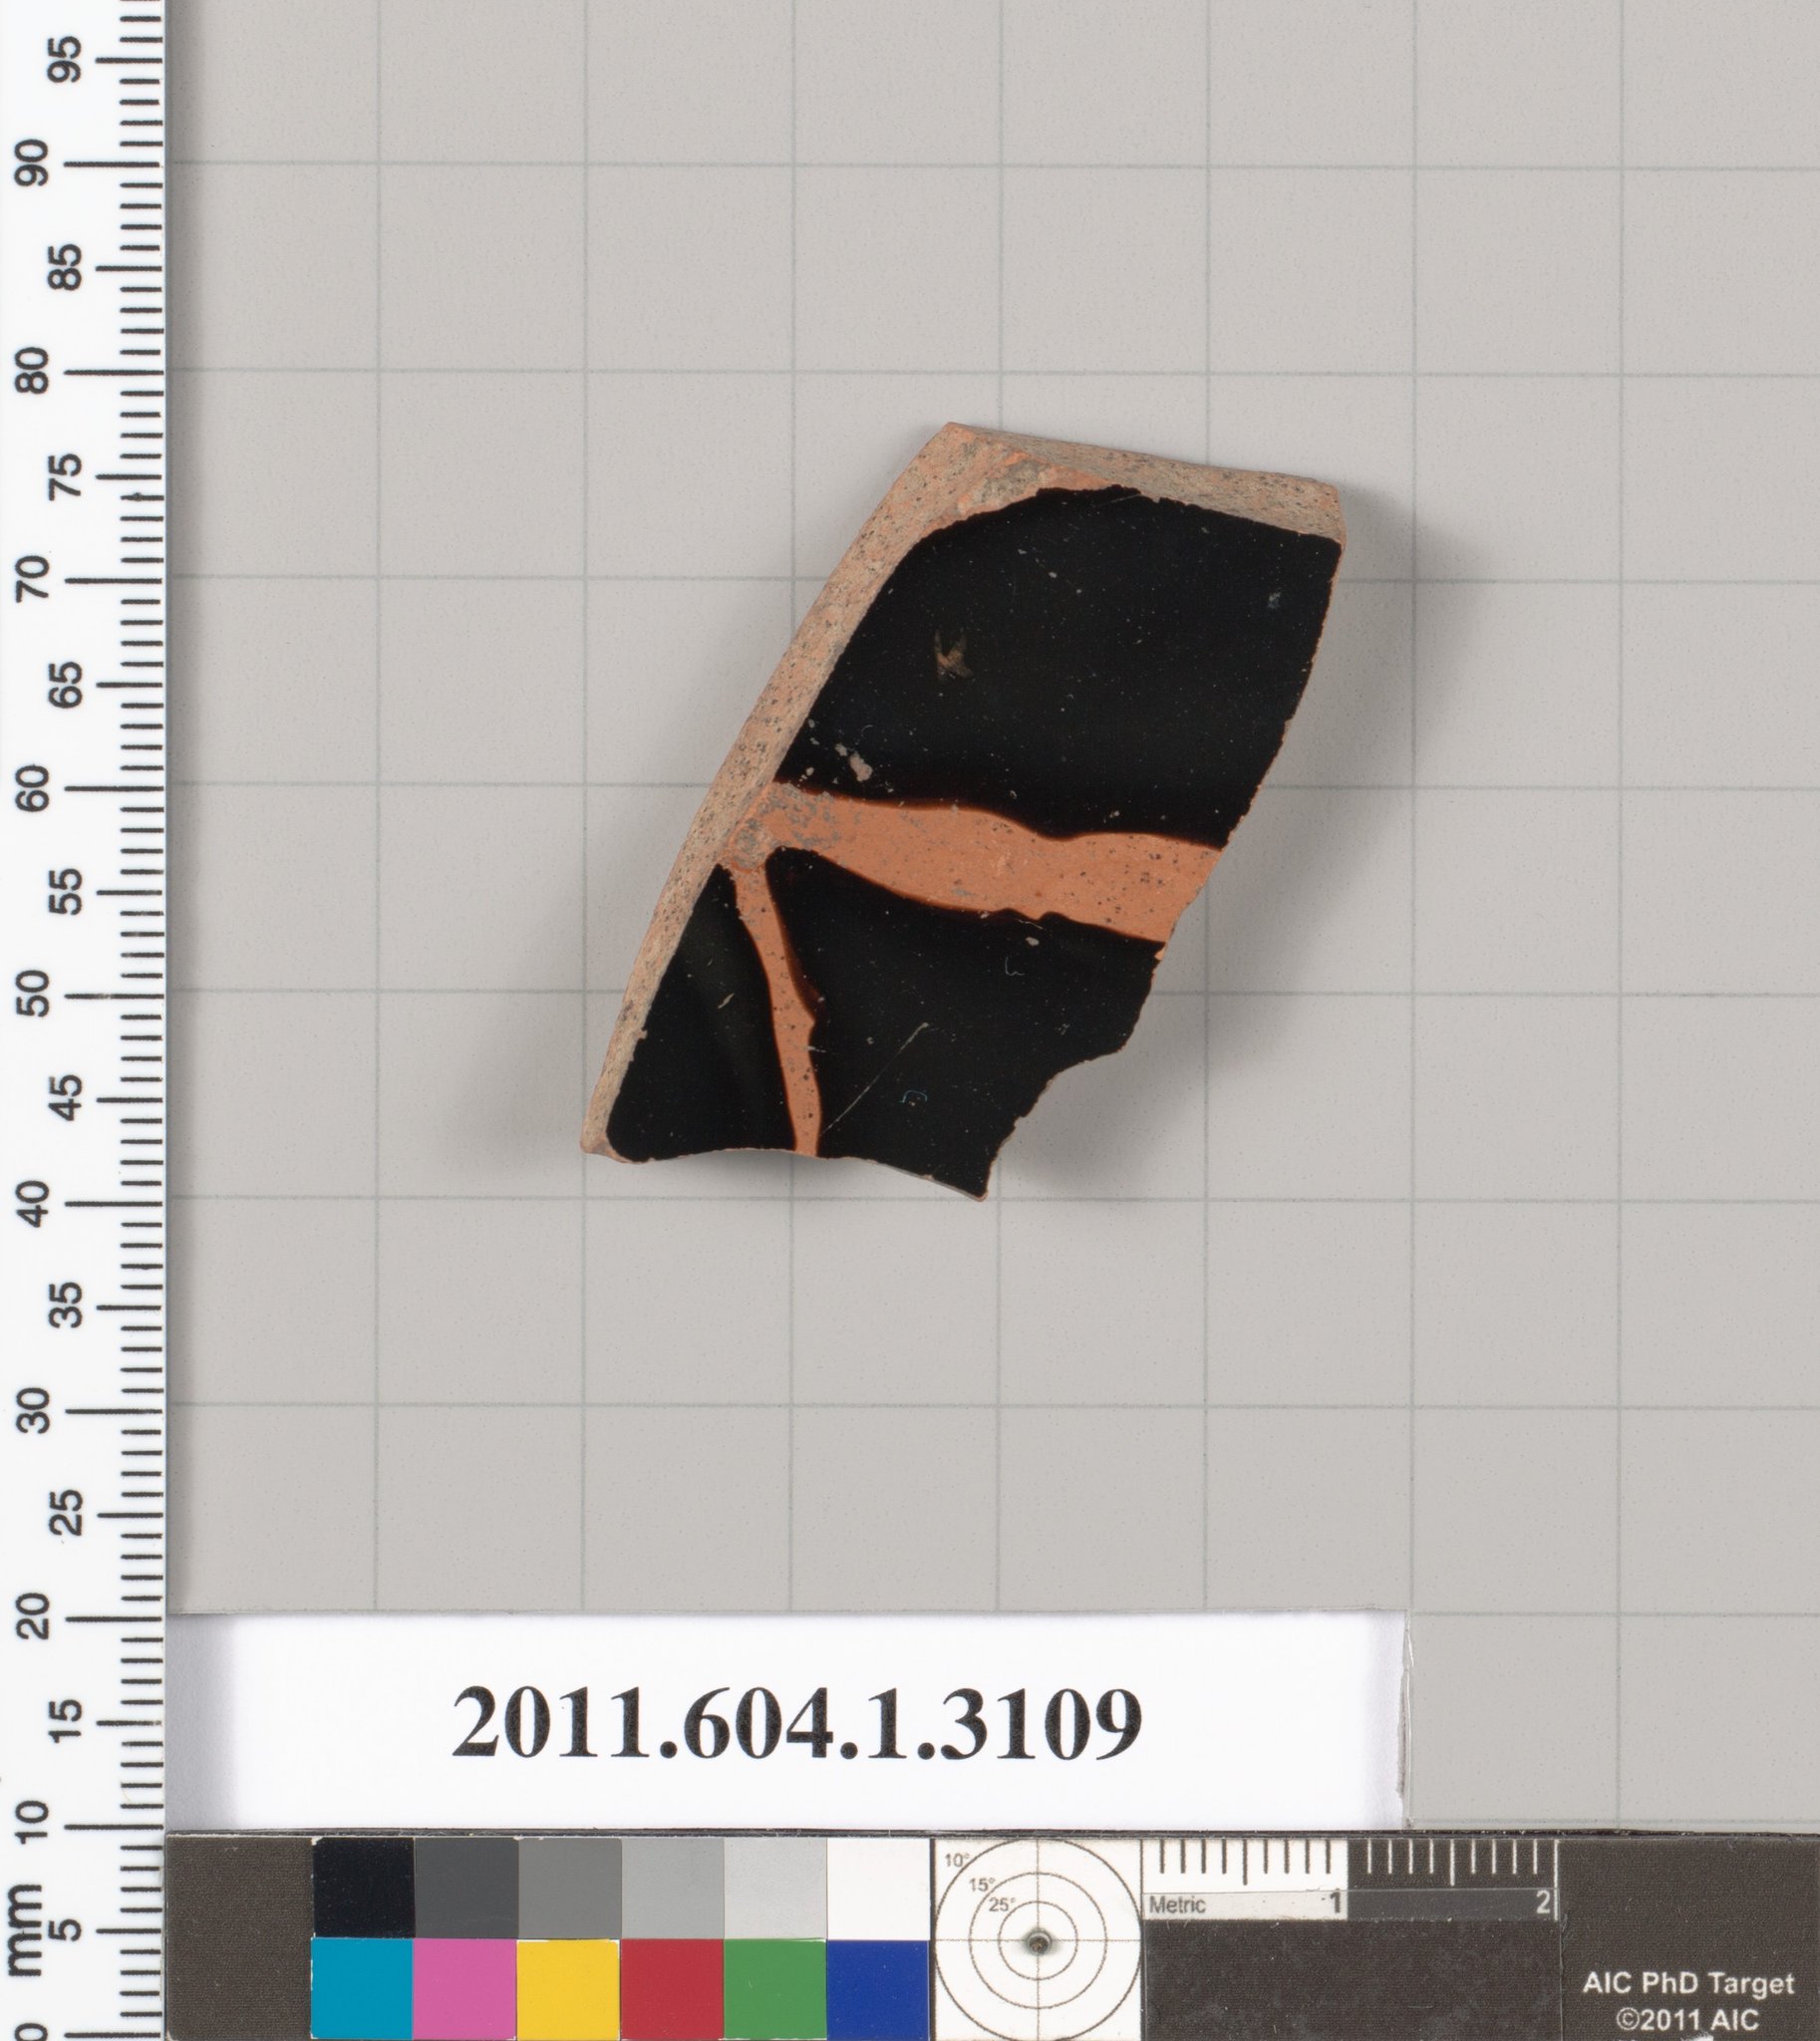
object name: kylix fragment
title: Terracotta fragment of a kylix (drinking cup)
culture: greek, attic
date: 500-451 BCE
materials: terracotta